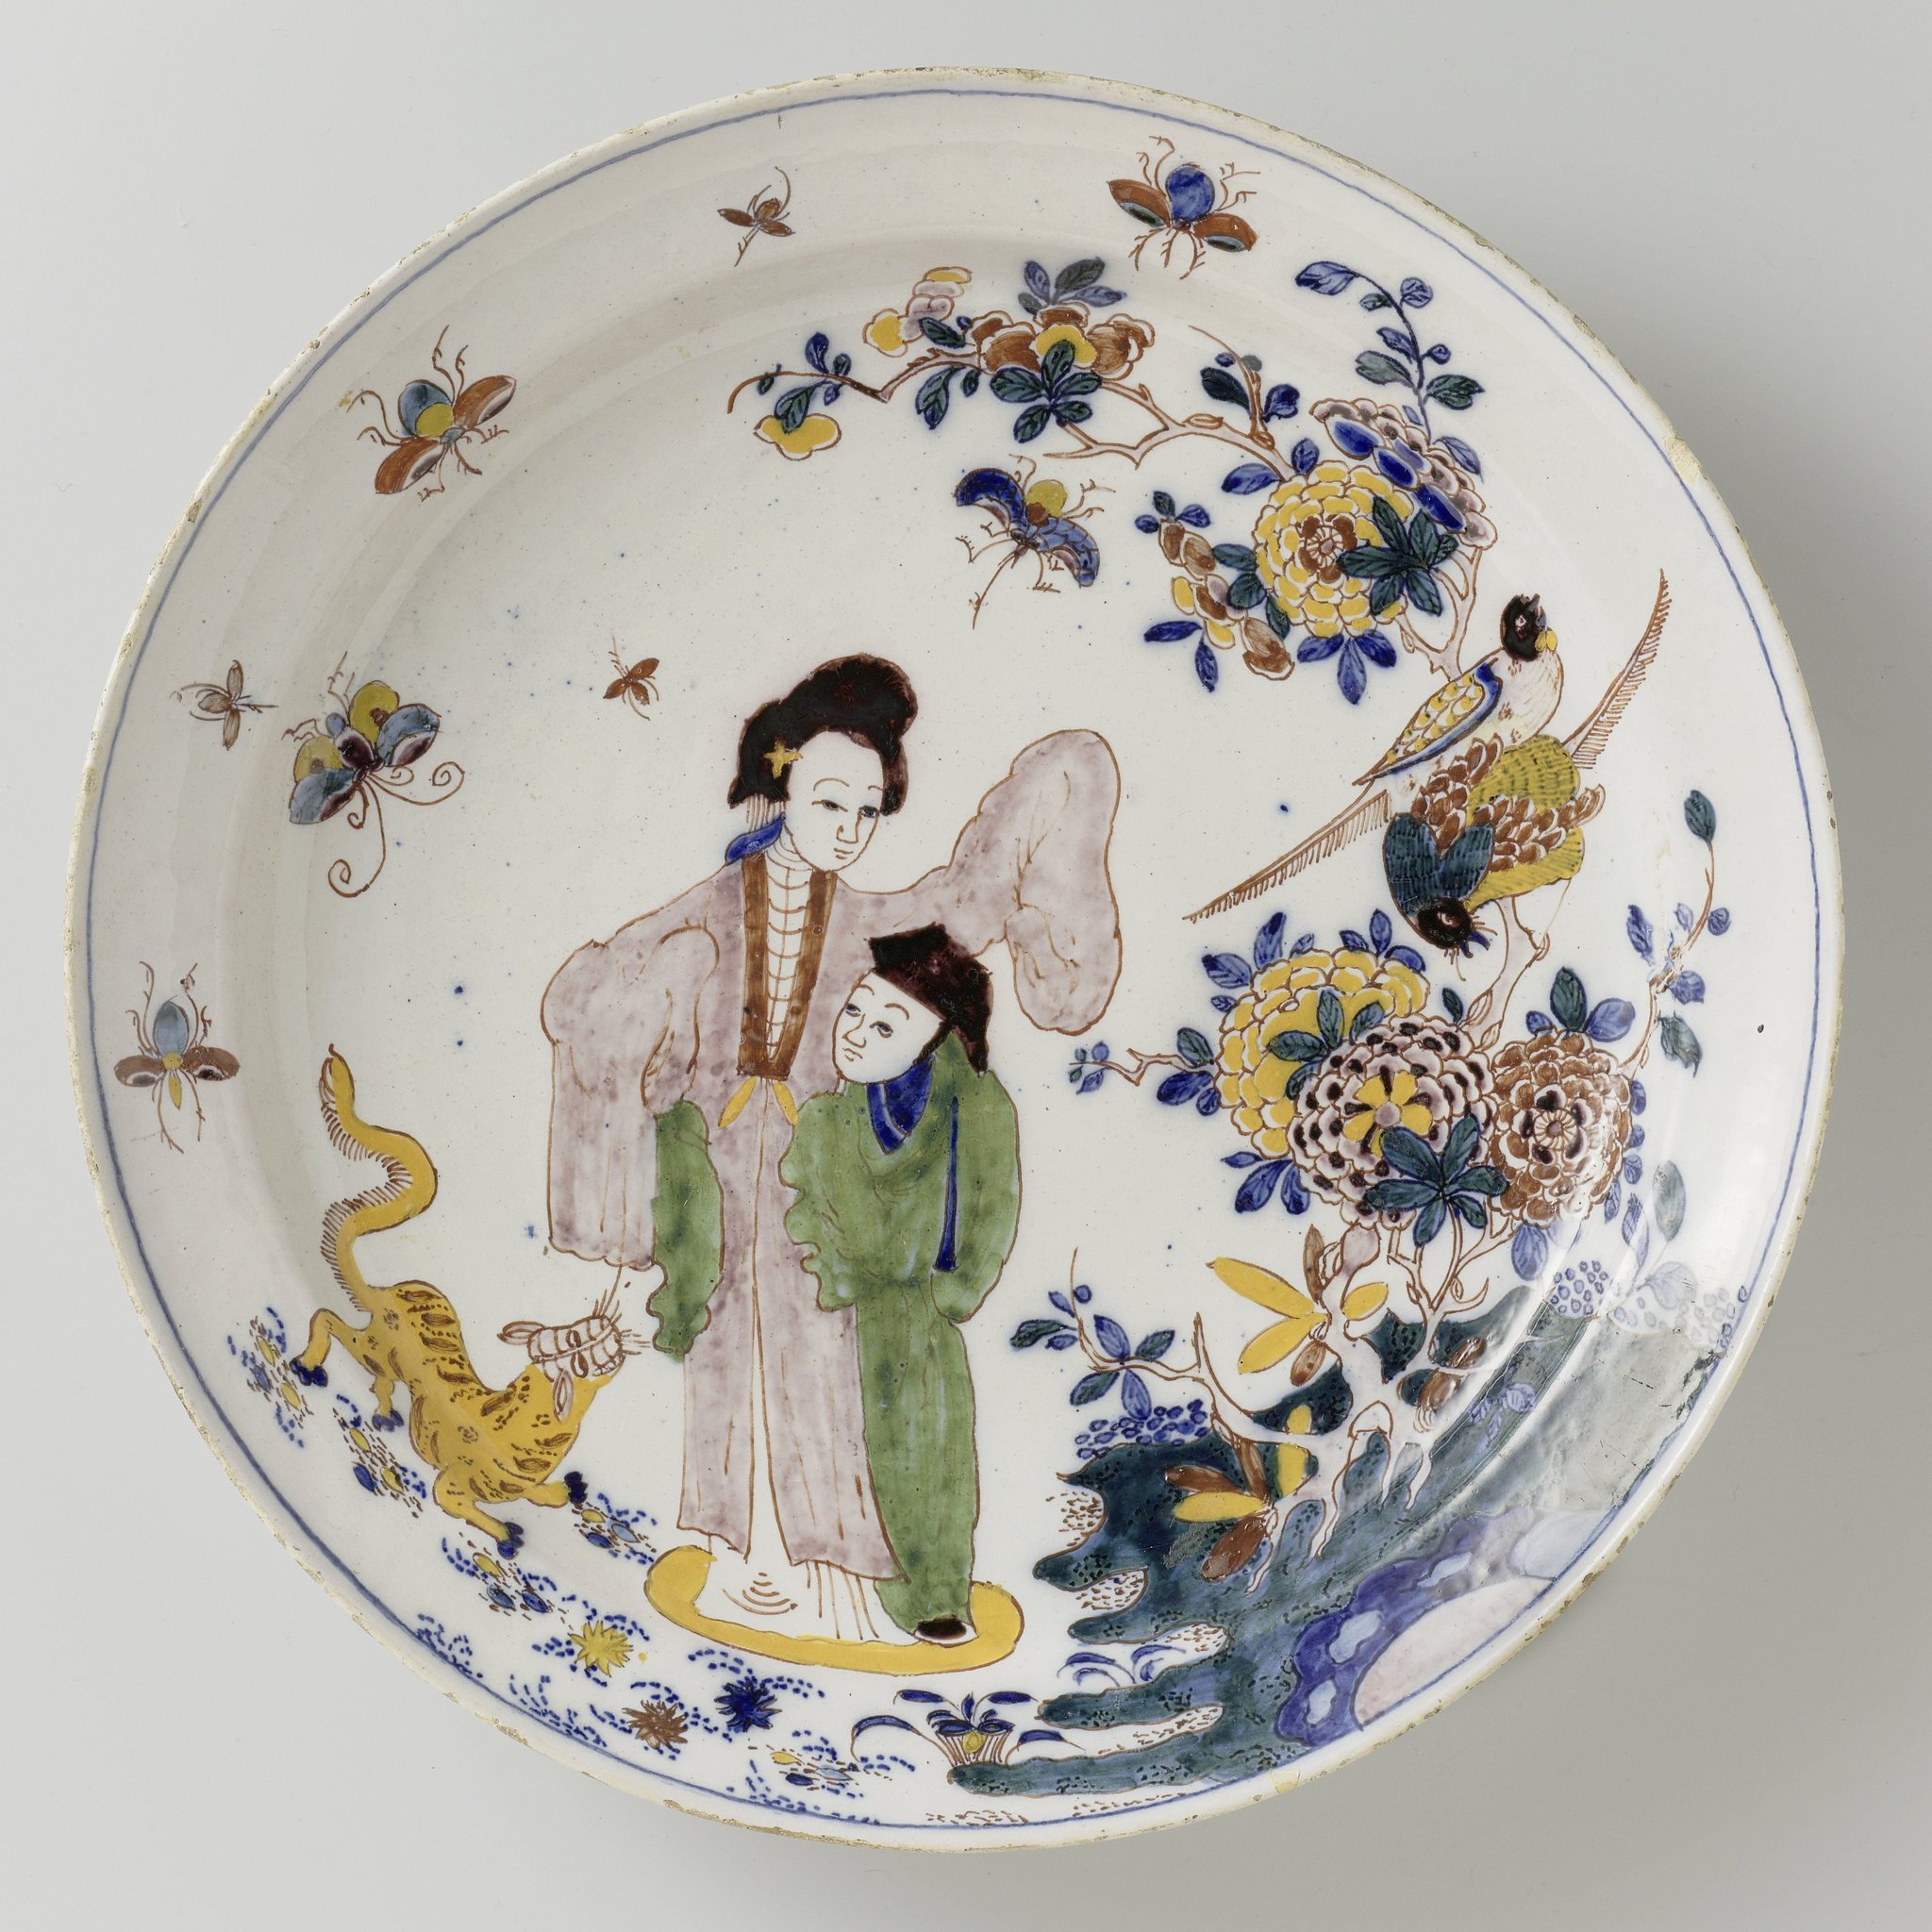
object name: platter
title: Schotel van veelkleurig beschilderde faience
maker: Anonymous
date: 1730-1770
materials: faience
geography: delft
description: Schotel van aardewerk bedekt met wit tinglazuur, waarop een voorstelling op het plat doorgaande over de rand geschilderd is in blauw, groen, geel, rood, violet en paarsbruin. Voorgesteld zijn twee Chinese figuren, een vrouw en een kind, staande, tegen elkaar geleund, op een geel ovaal grondje. Links van hen een gele tijger, rechts rotsen met bloeiende planten met twee vogels. In de lucht een aantal insekten. Rode contouren. Een blauwe bies langs de rand.